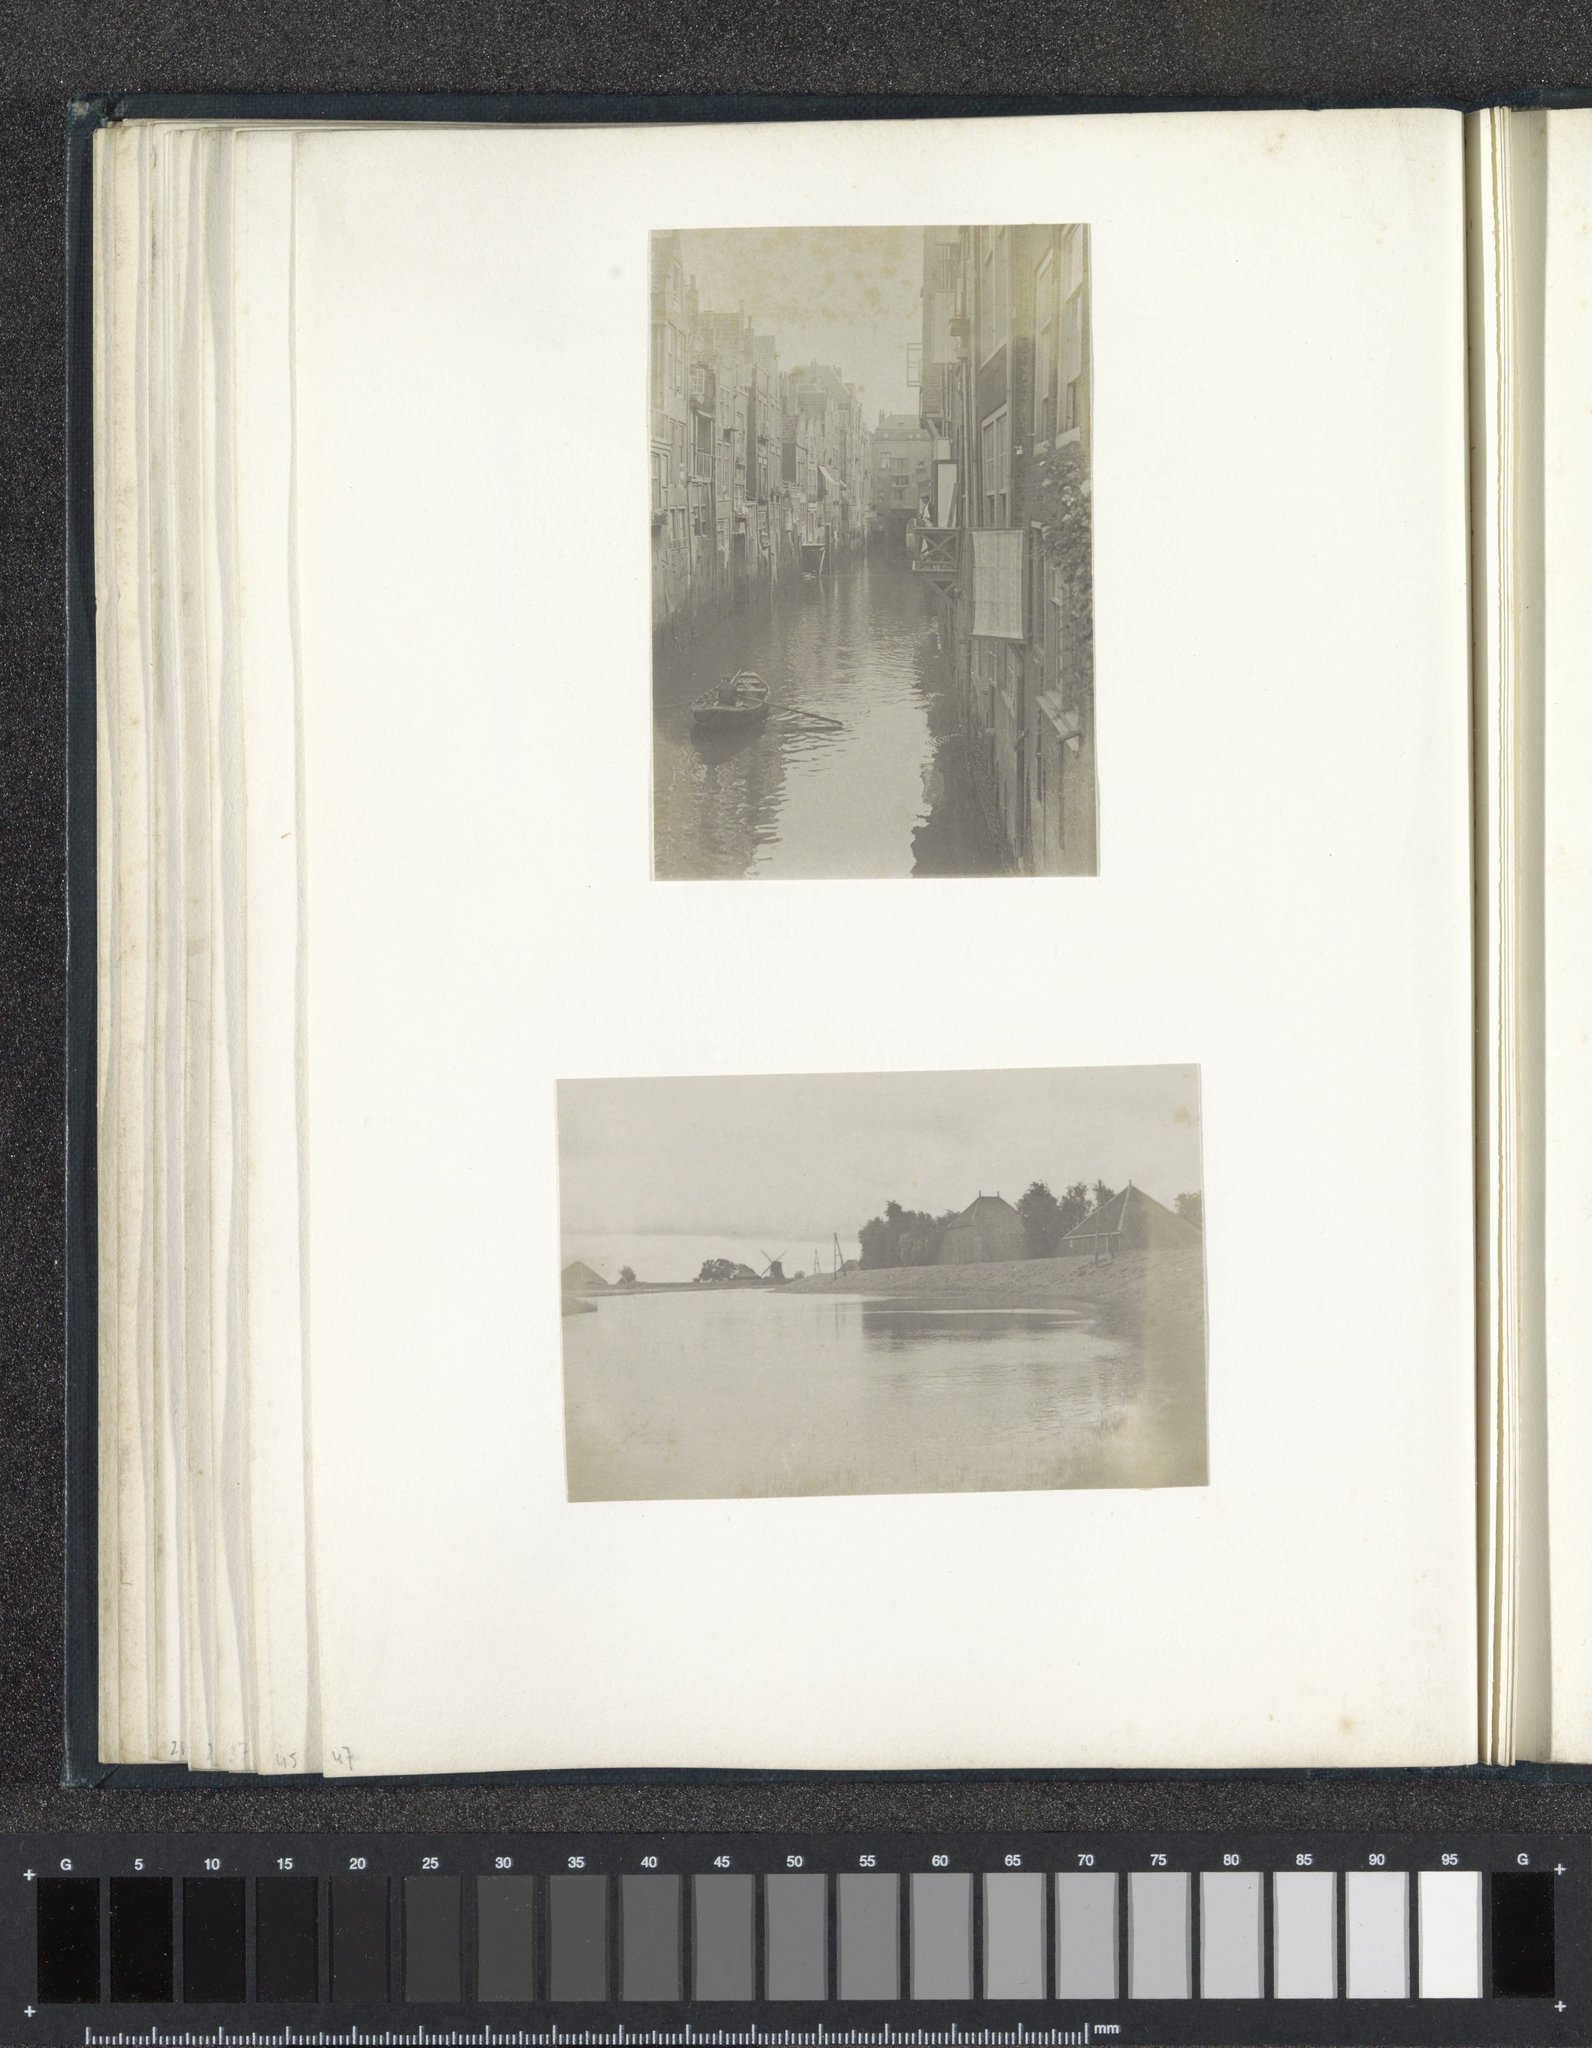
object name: photograph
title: Doorkijk in de Voorstraatshaven in Dordrecht met op de achtergrond de overkluizing van het Scheffersplein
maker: george hidderley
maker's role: fotograaf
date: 1900-1910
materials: paper, photographic support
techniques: gelatin silver print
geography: dordrecht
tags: canal, dordrecht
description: Onderdeel van fotoalbum met opnames van Volendam, Dordrecht, Gorinchem en Woudrichem.